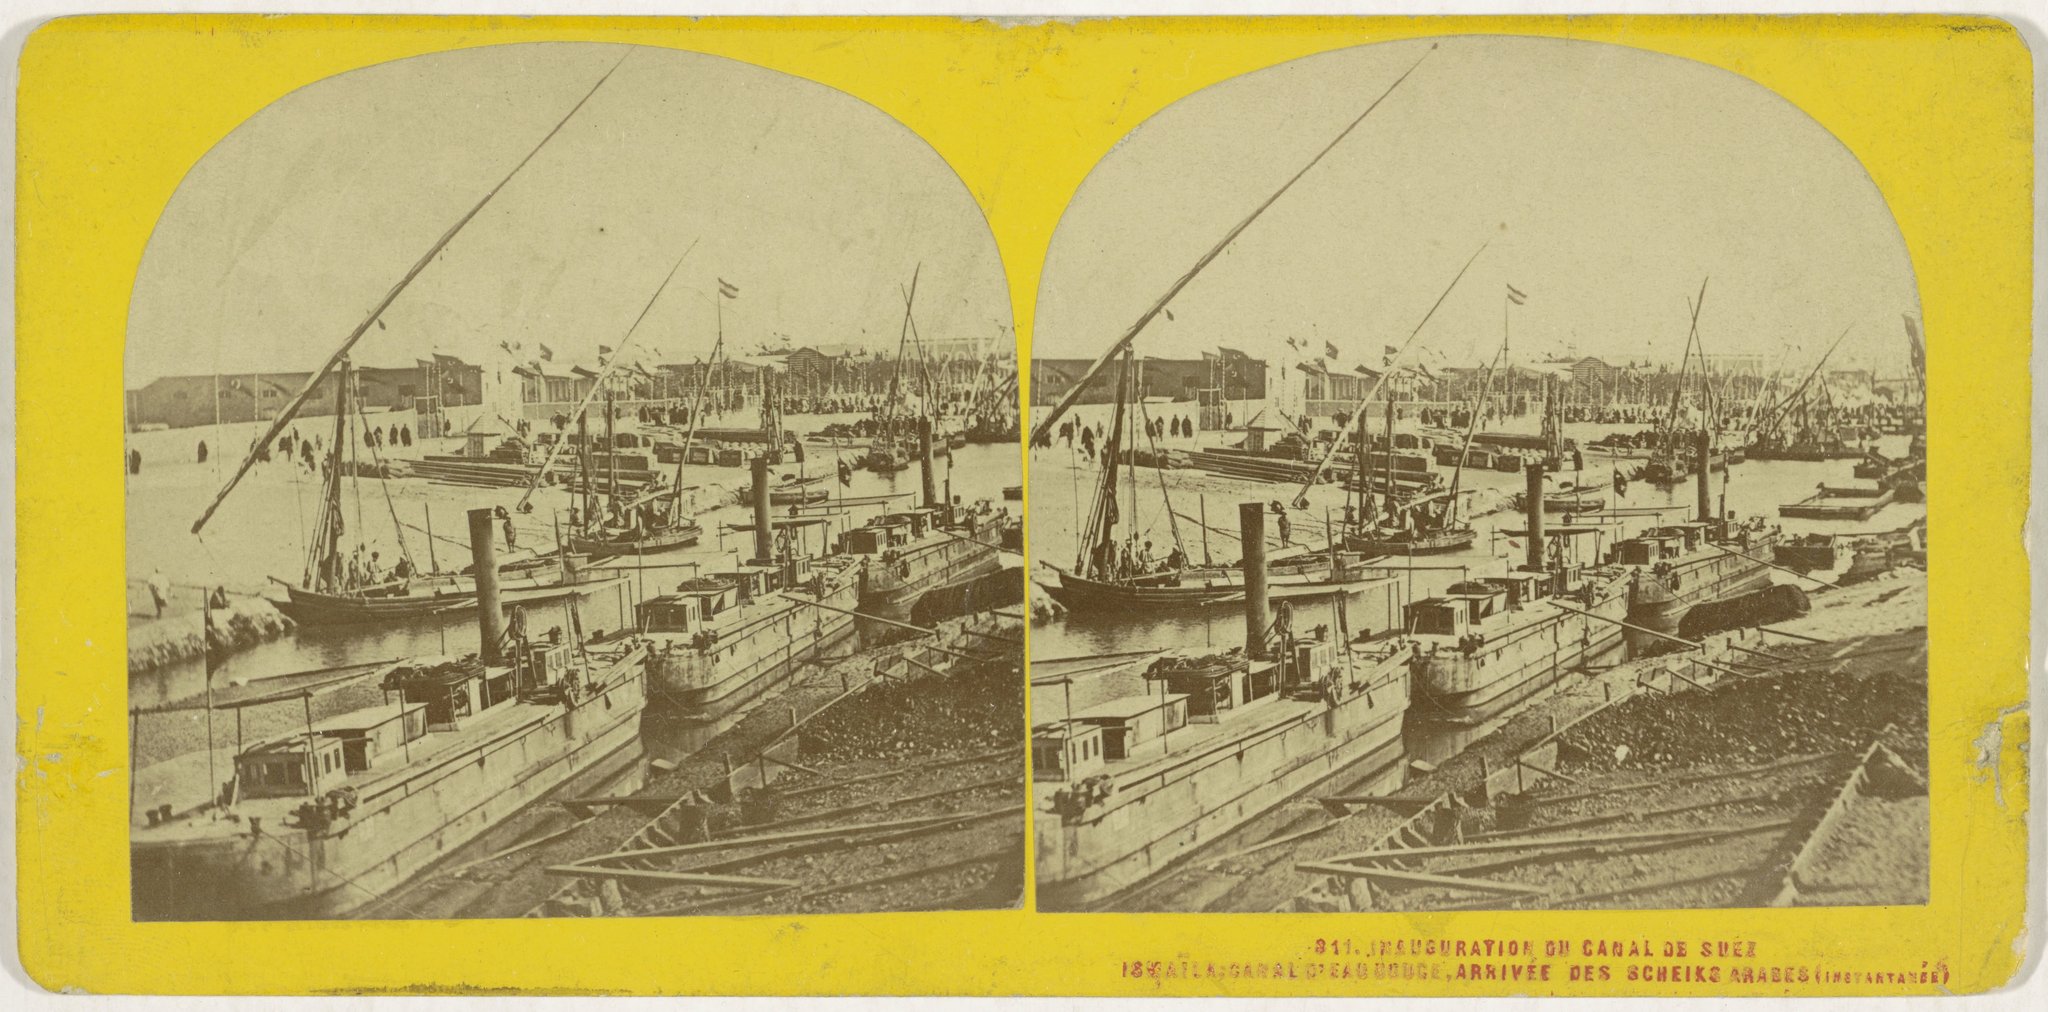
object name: stereograph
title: Inauguration du Canal de Suez, Ismaïla; canal d'eau douce, arrivée des scheiks Arabes (instantanée)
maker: Anonymous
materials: cardboard, paper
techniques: albumen print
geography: ismailia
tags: harbour, canal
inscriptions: number: ‘811.’